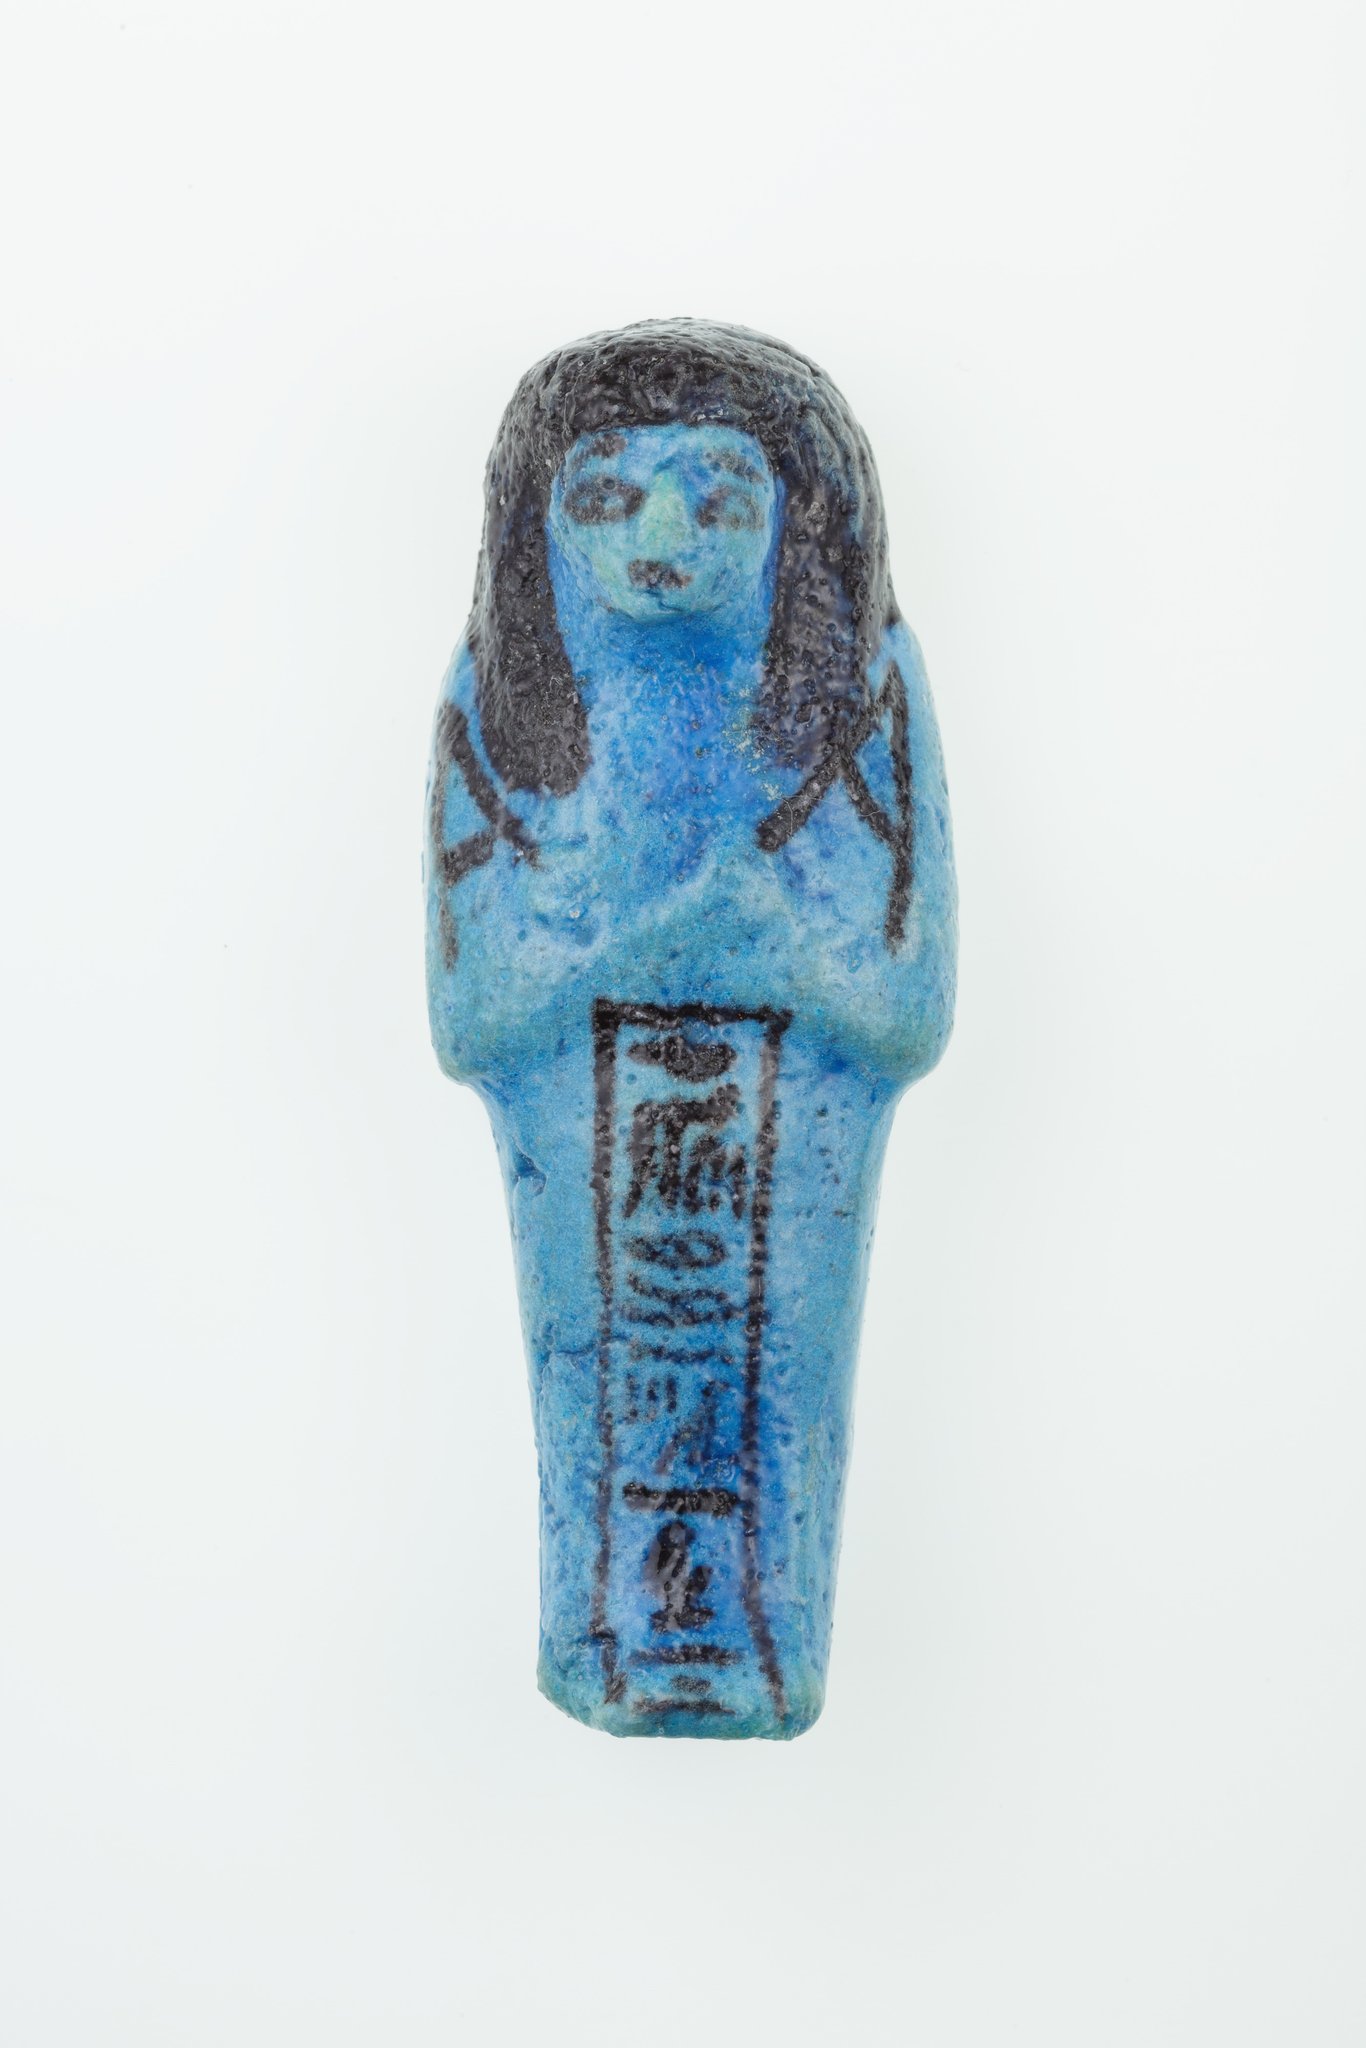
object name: shabti, worker, nauny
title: Worker Shabti of Nauny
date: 1050 BCE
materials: faience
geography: egypt